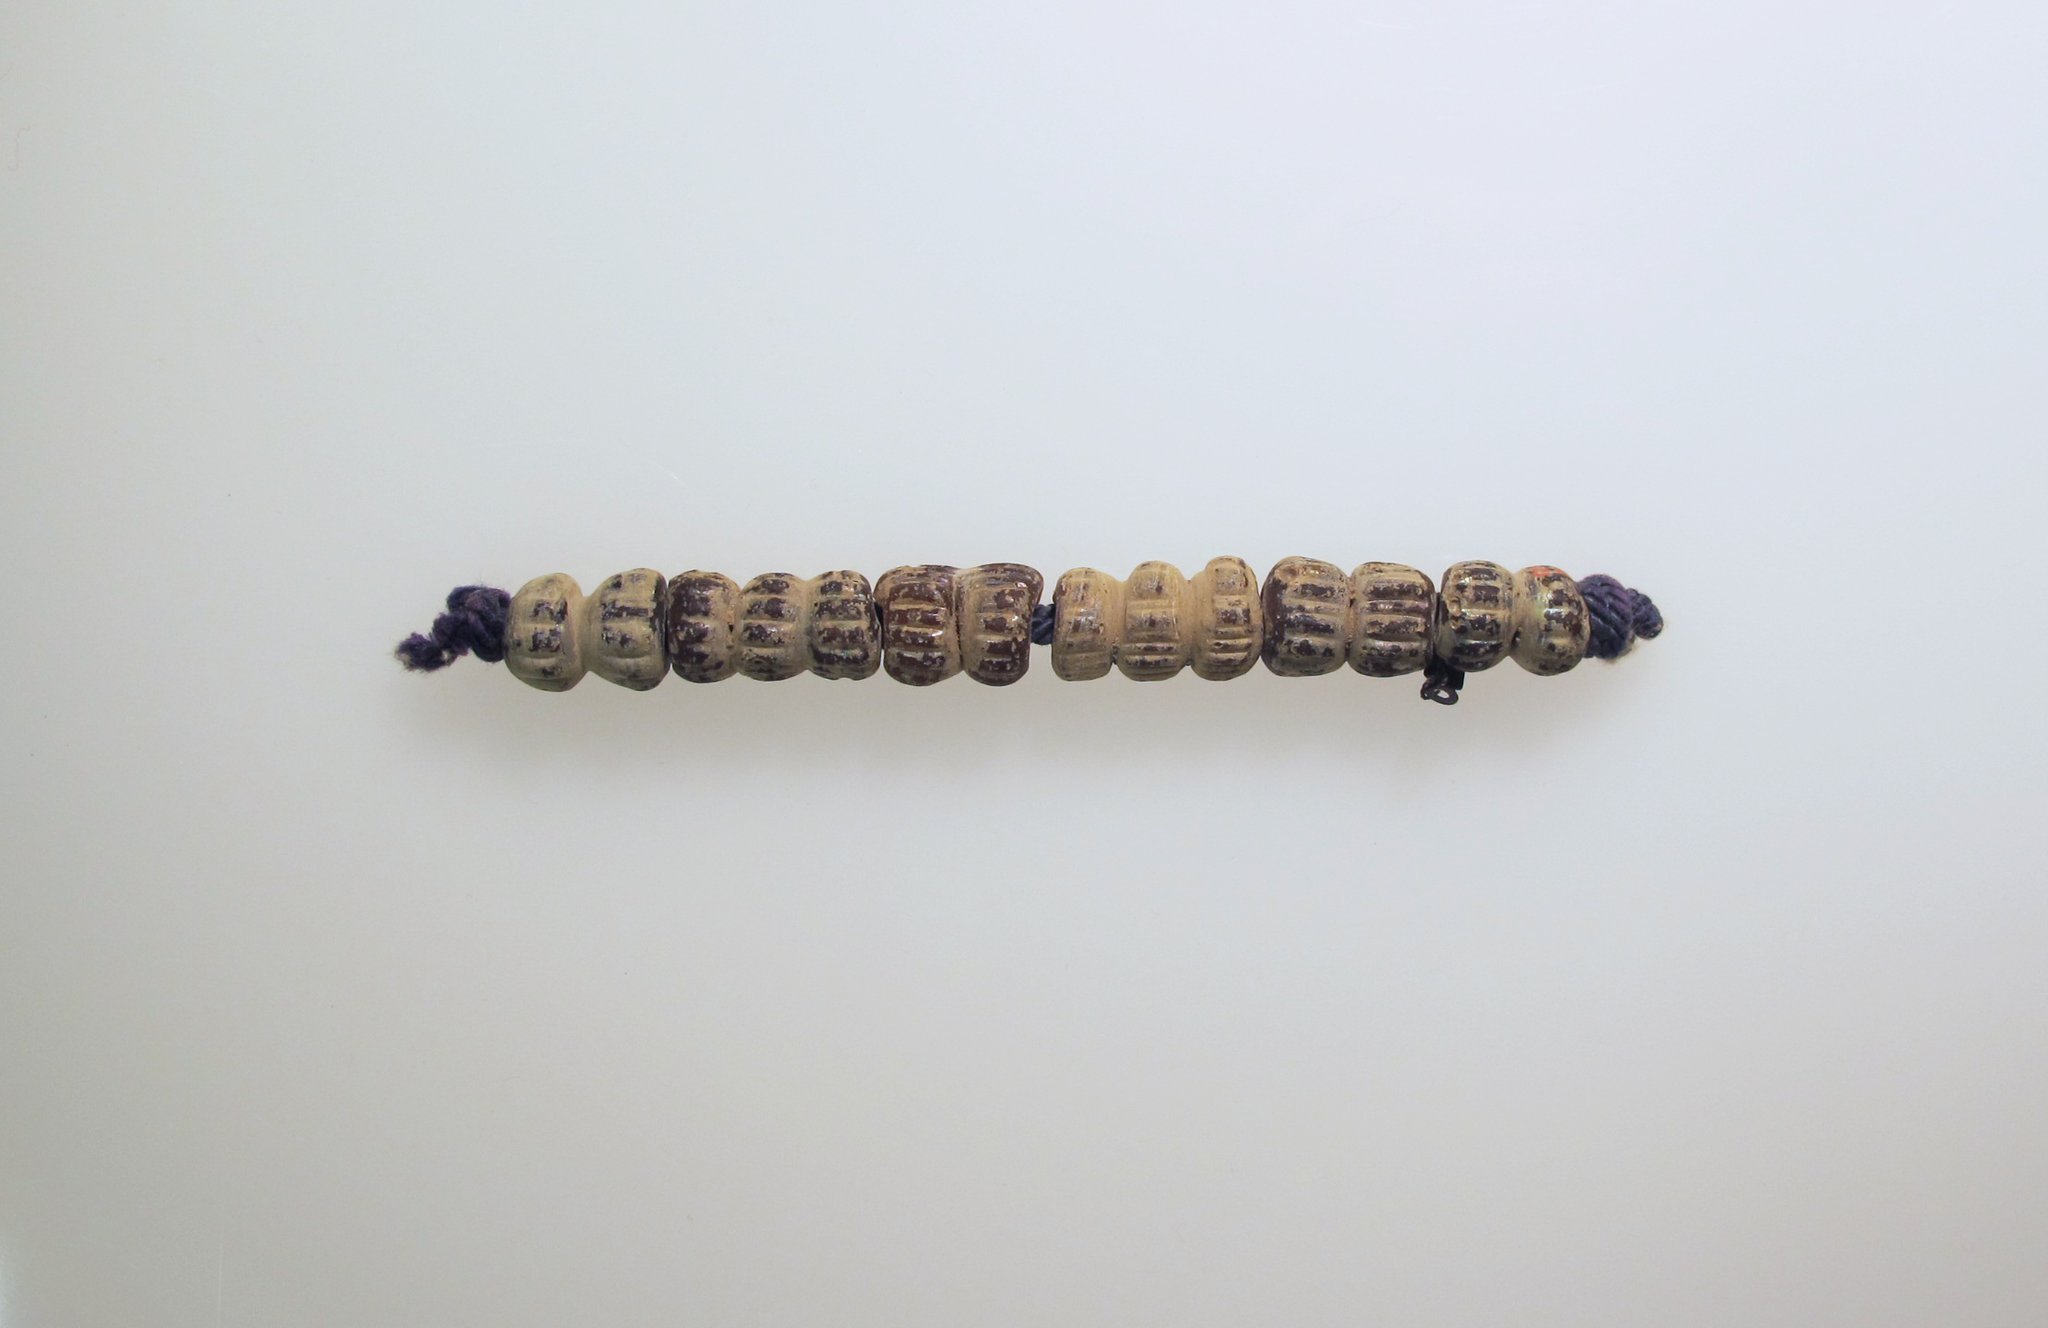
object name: bead, 6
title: Beads, 6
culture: roman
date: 670 BCE-330 CE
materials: glass